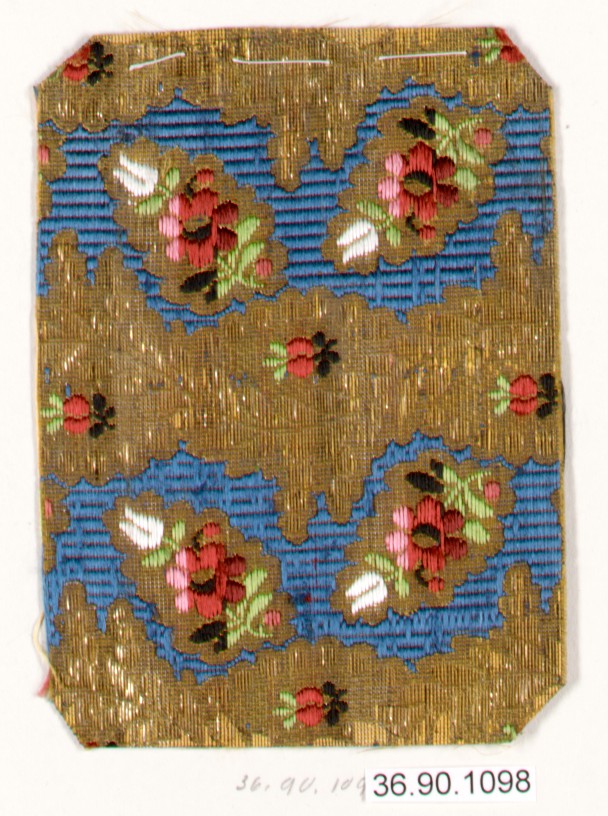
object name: sample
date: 1701-1900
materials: metal thread, silk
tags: flowers